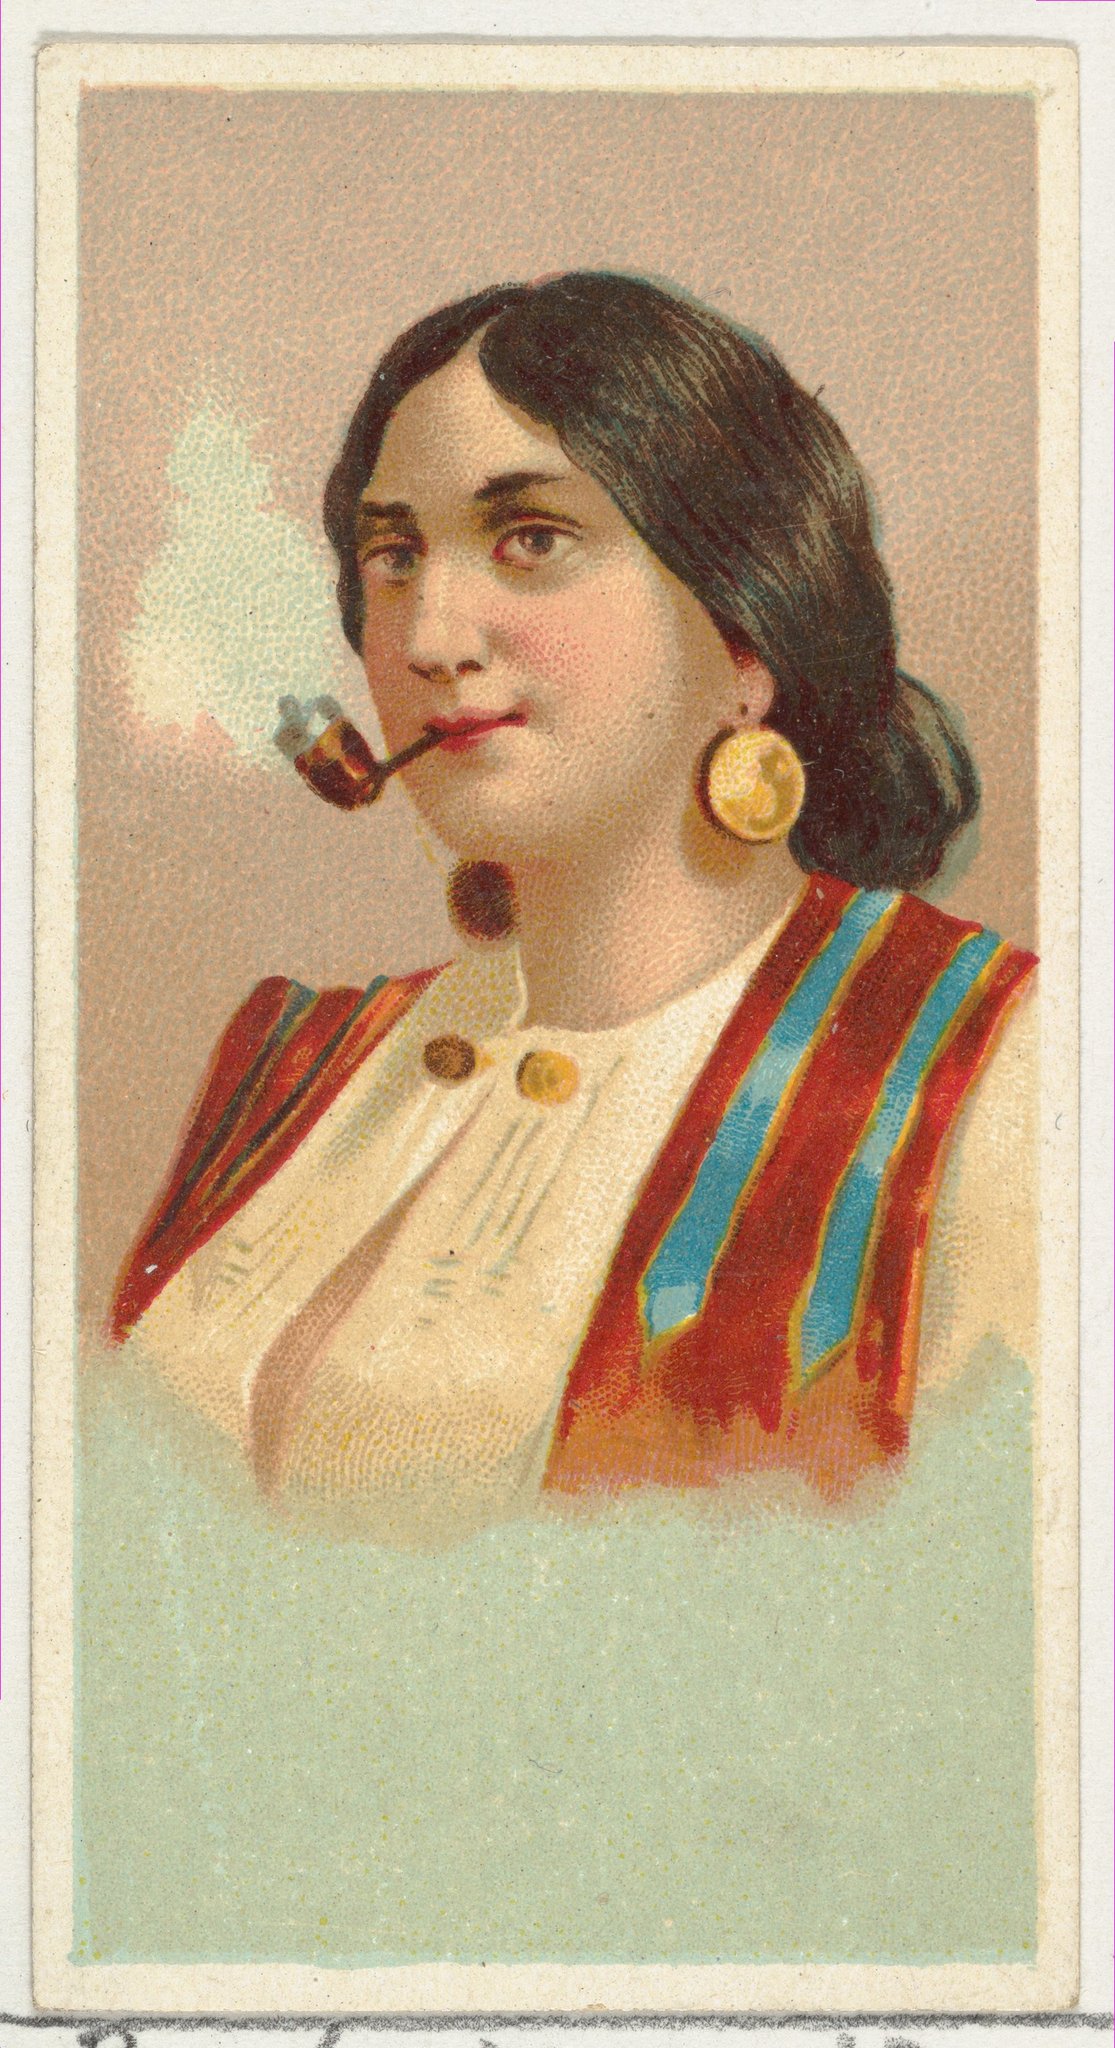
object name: print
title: Gypsy Girl, printer's sample from World's Smokers series (N33) for Allen & Ginter Cigarettes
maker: allen & ginter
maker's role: publisher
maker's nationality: american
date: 1888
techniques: color lithograph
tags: women,smoking